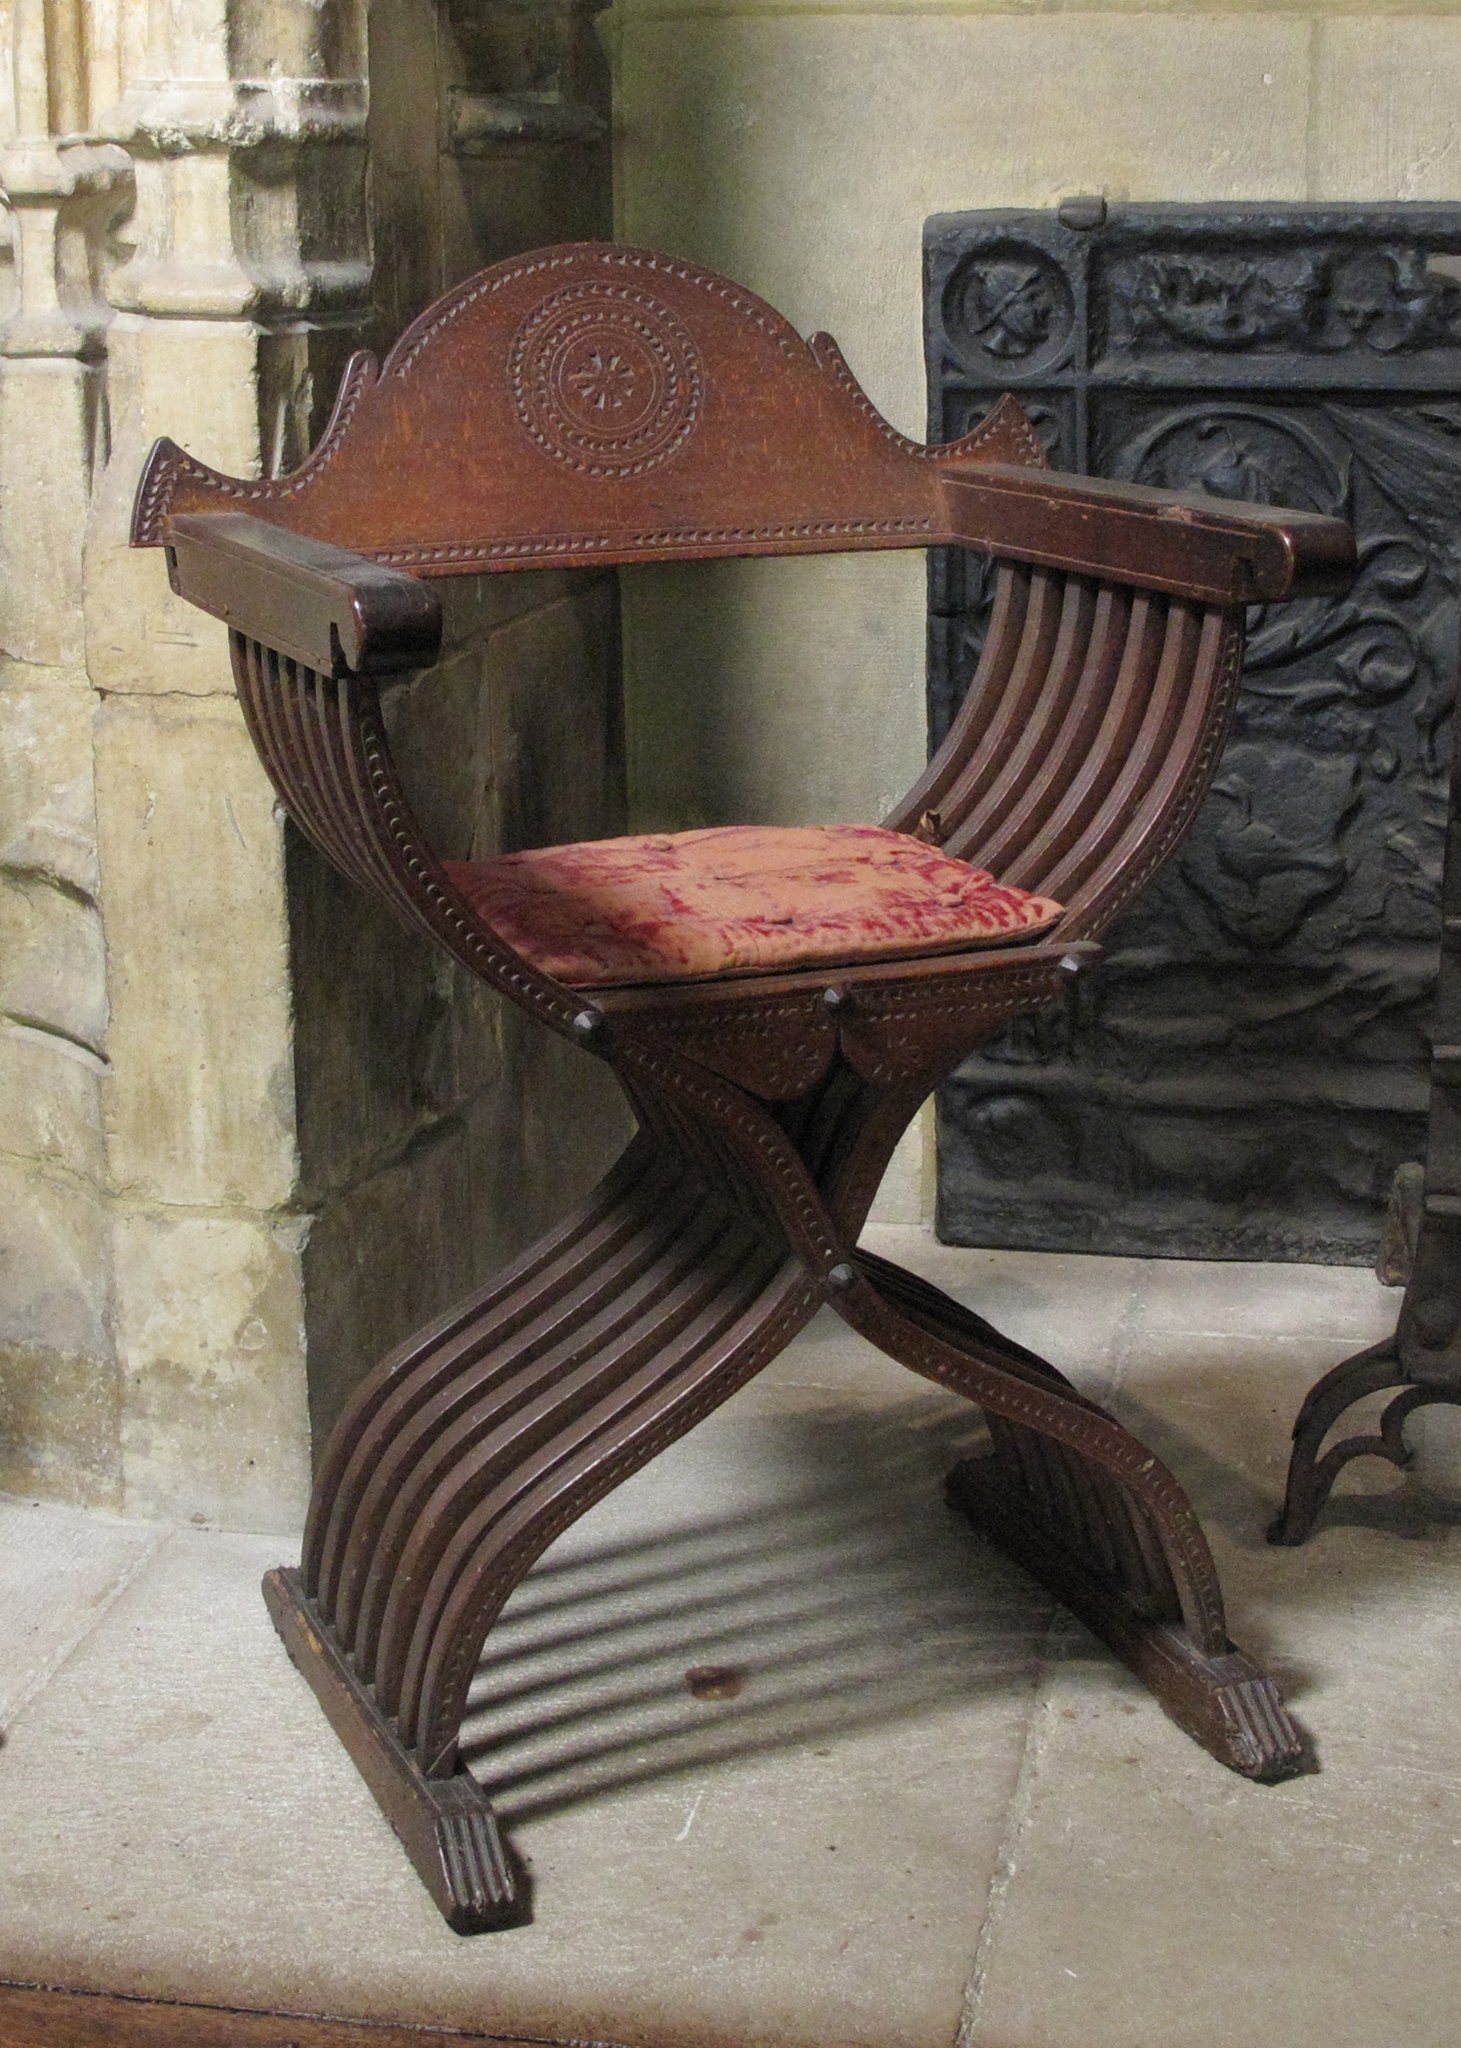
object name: chair, savonarola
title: Folding Armchair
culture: italian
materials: wood